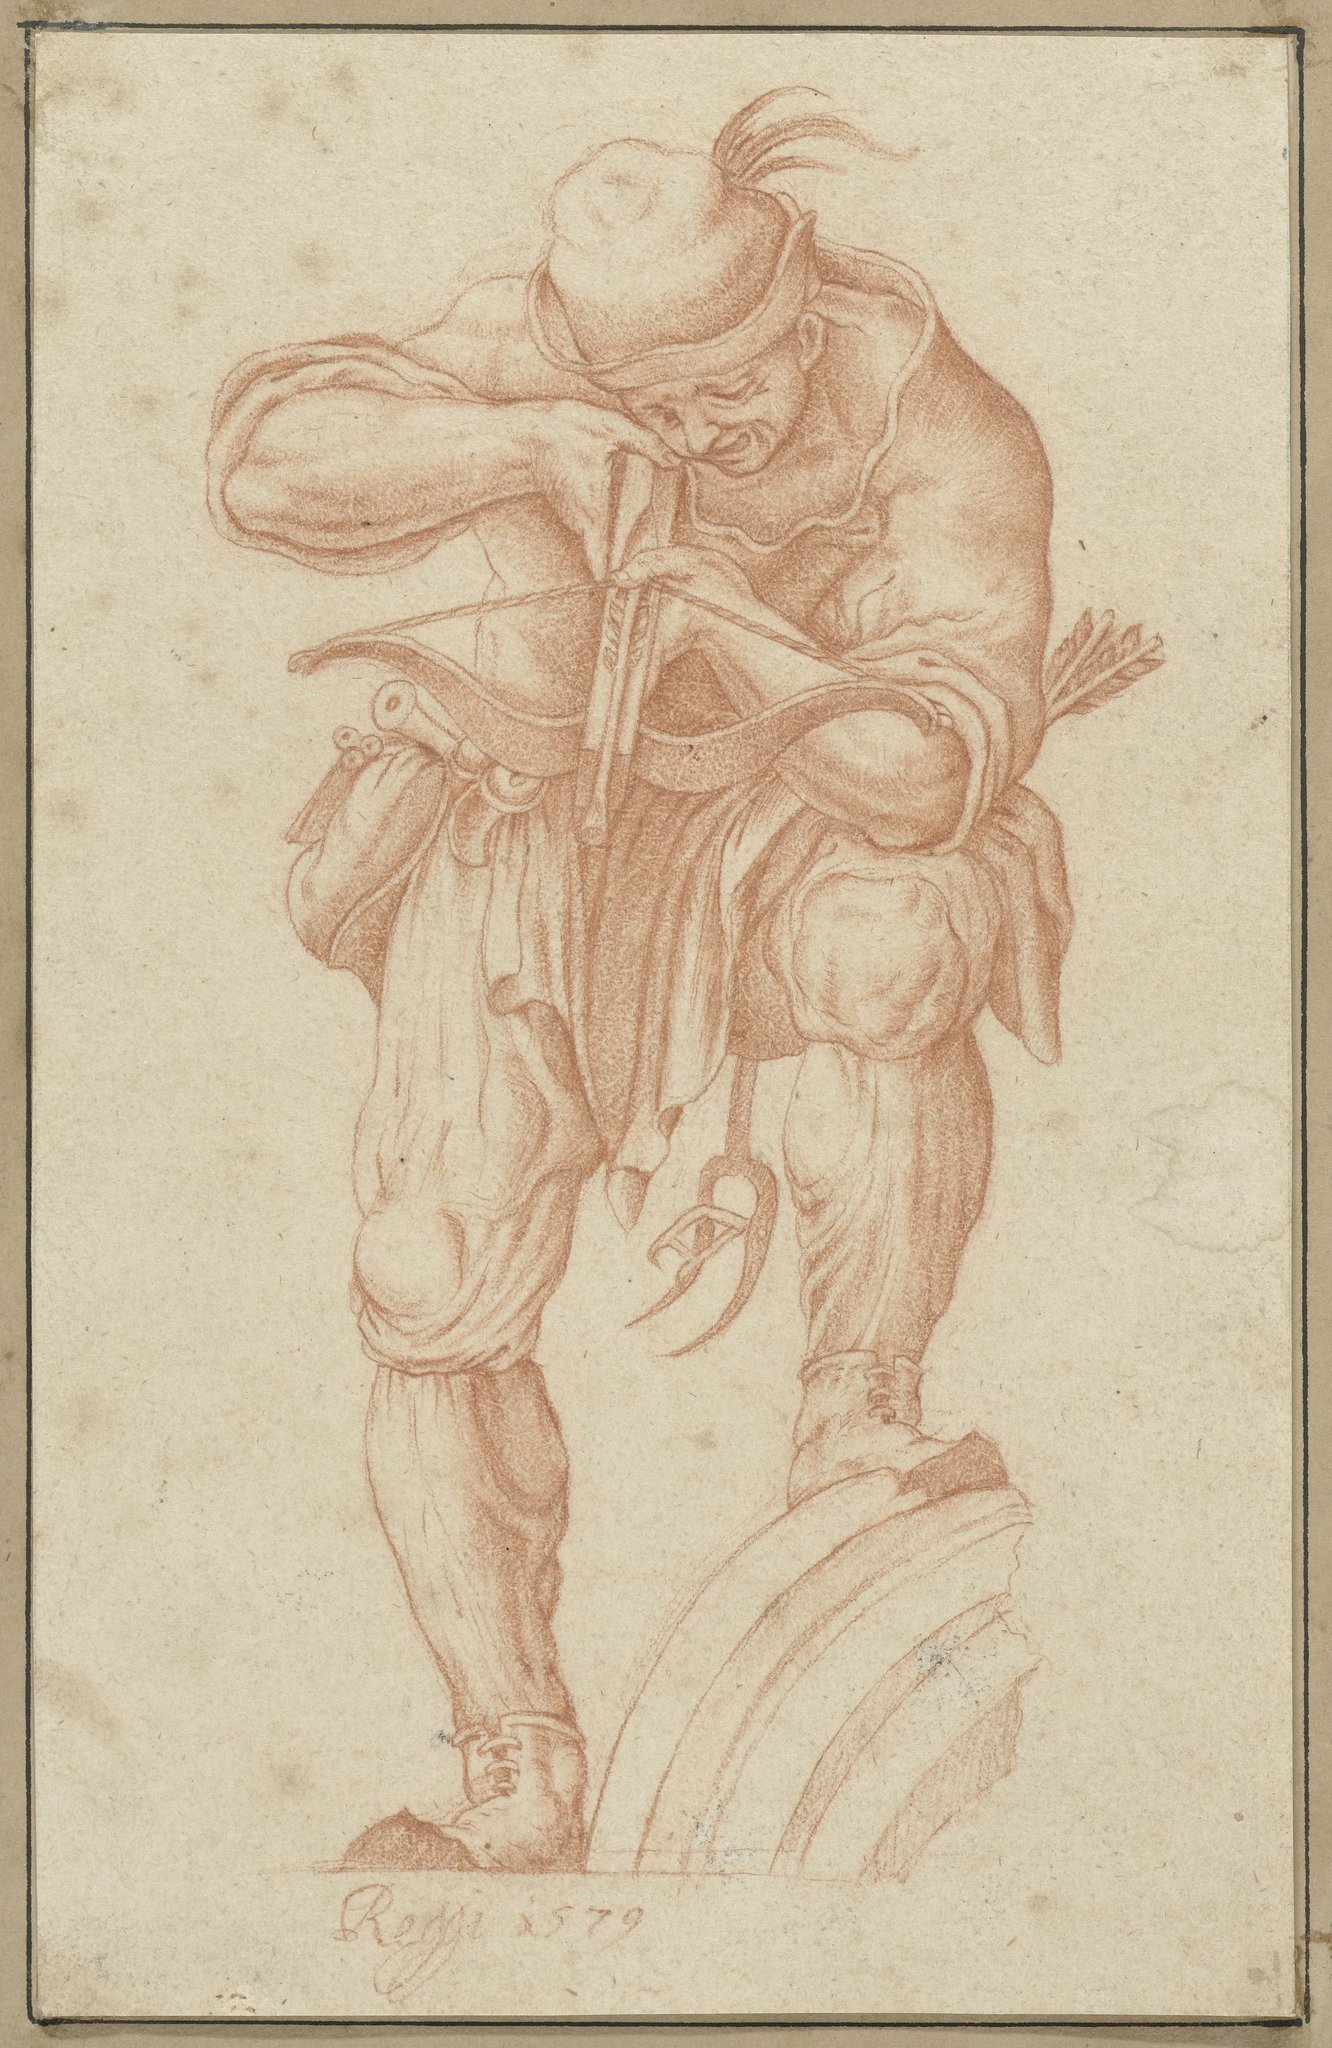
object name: drawing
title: Boogschutter, naar beneden mikkend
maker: Anonymous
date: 1579-1620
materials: chalk, paper